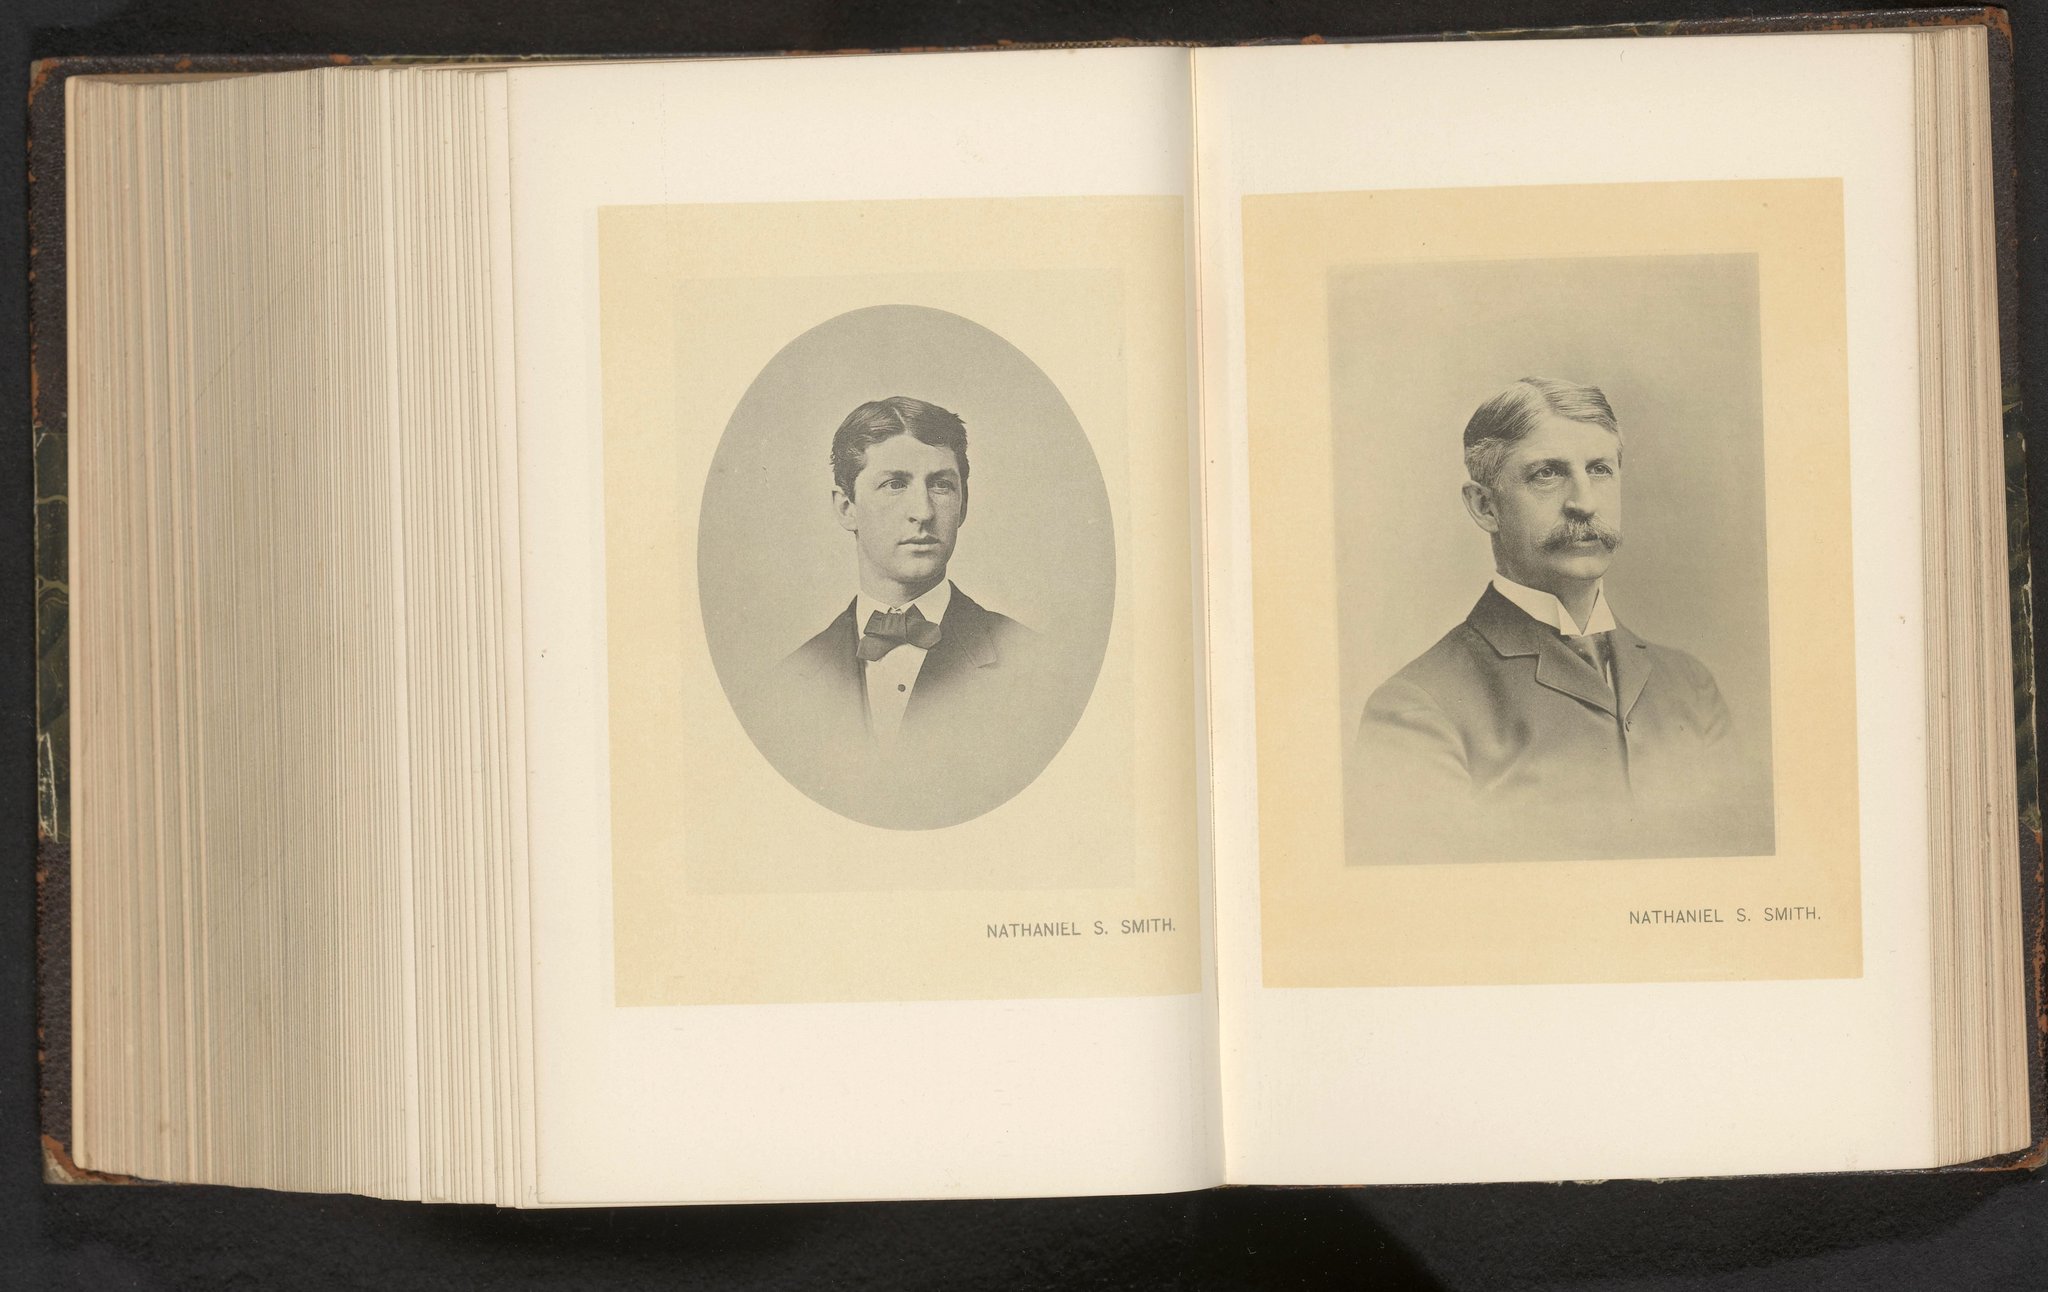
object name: page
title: Nathaniel S. Smith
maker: Anonymous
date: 1869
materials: paper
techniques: photoaquatint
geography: boston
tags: adult man